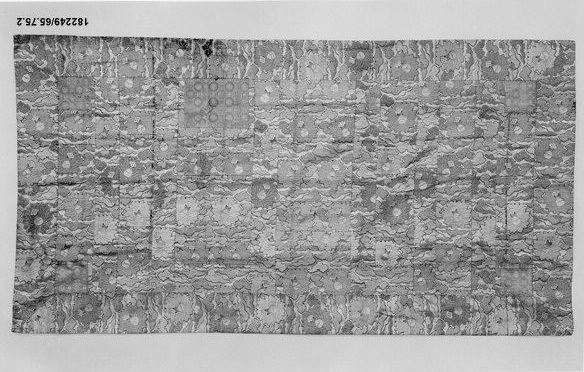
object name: robe, priest's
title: Priest's Robe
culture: japanese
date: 1601-1800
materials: metal thread, silk